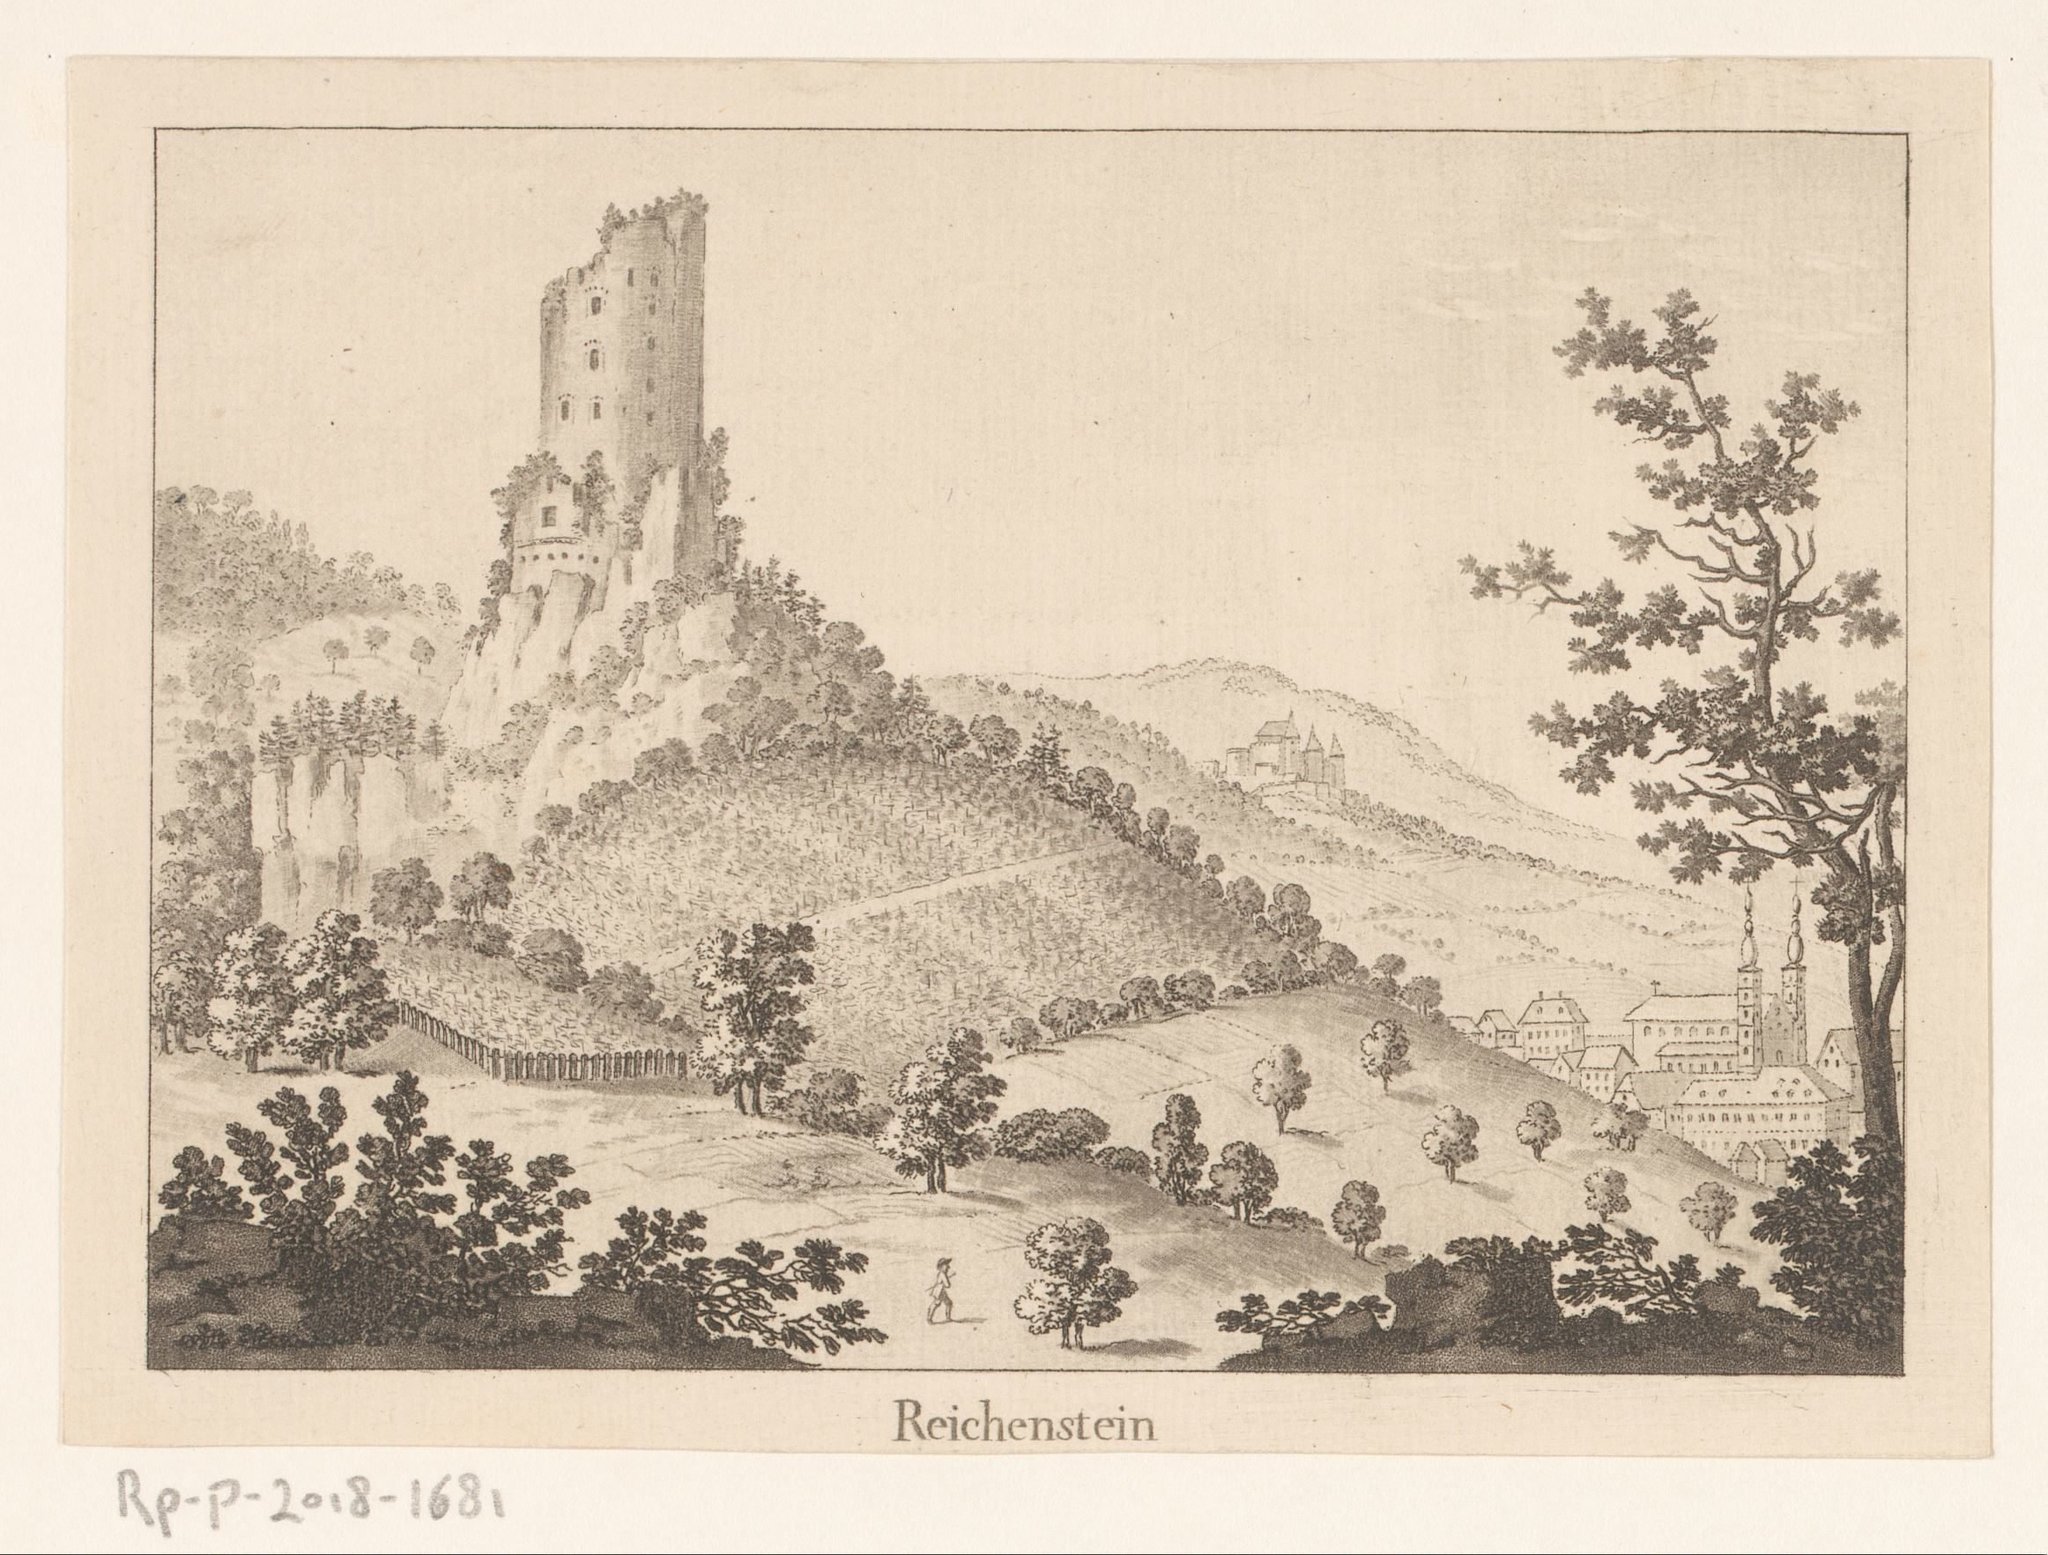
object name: print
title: Reichenstein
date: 1810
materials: paper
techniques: aquatint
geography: amsterdam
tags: castle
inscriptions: collector's mark: Lugt 2228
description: Prent ook gebruikt in: Promenade Pittoresque dans l'évêché de bâle aux bords de la Birs (...). Amsterdam: T.B. Groebe, 1710.